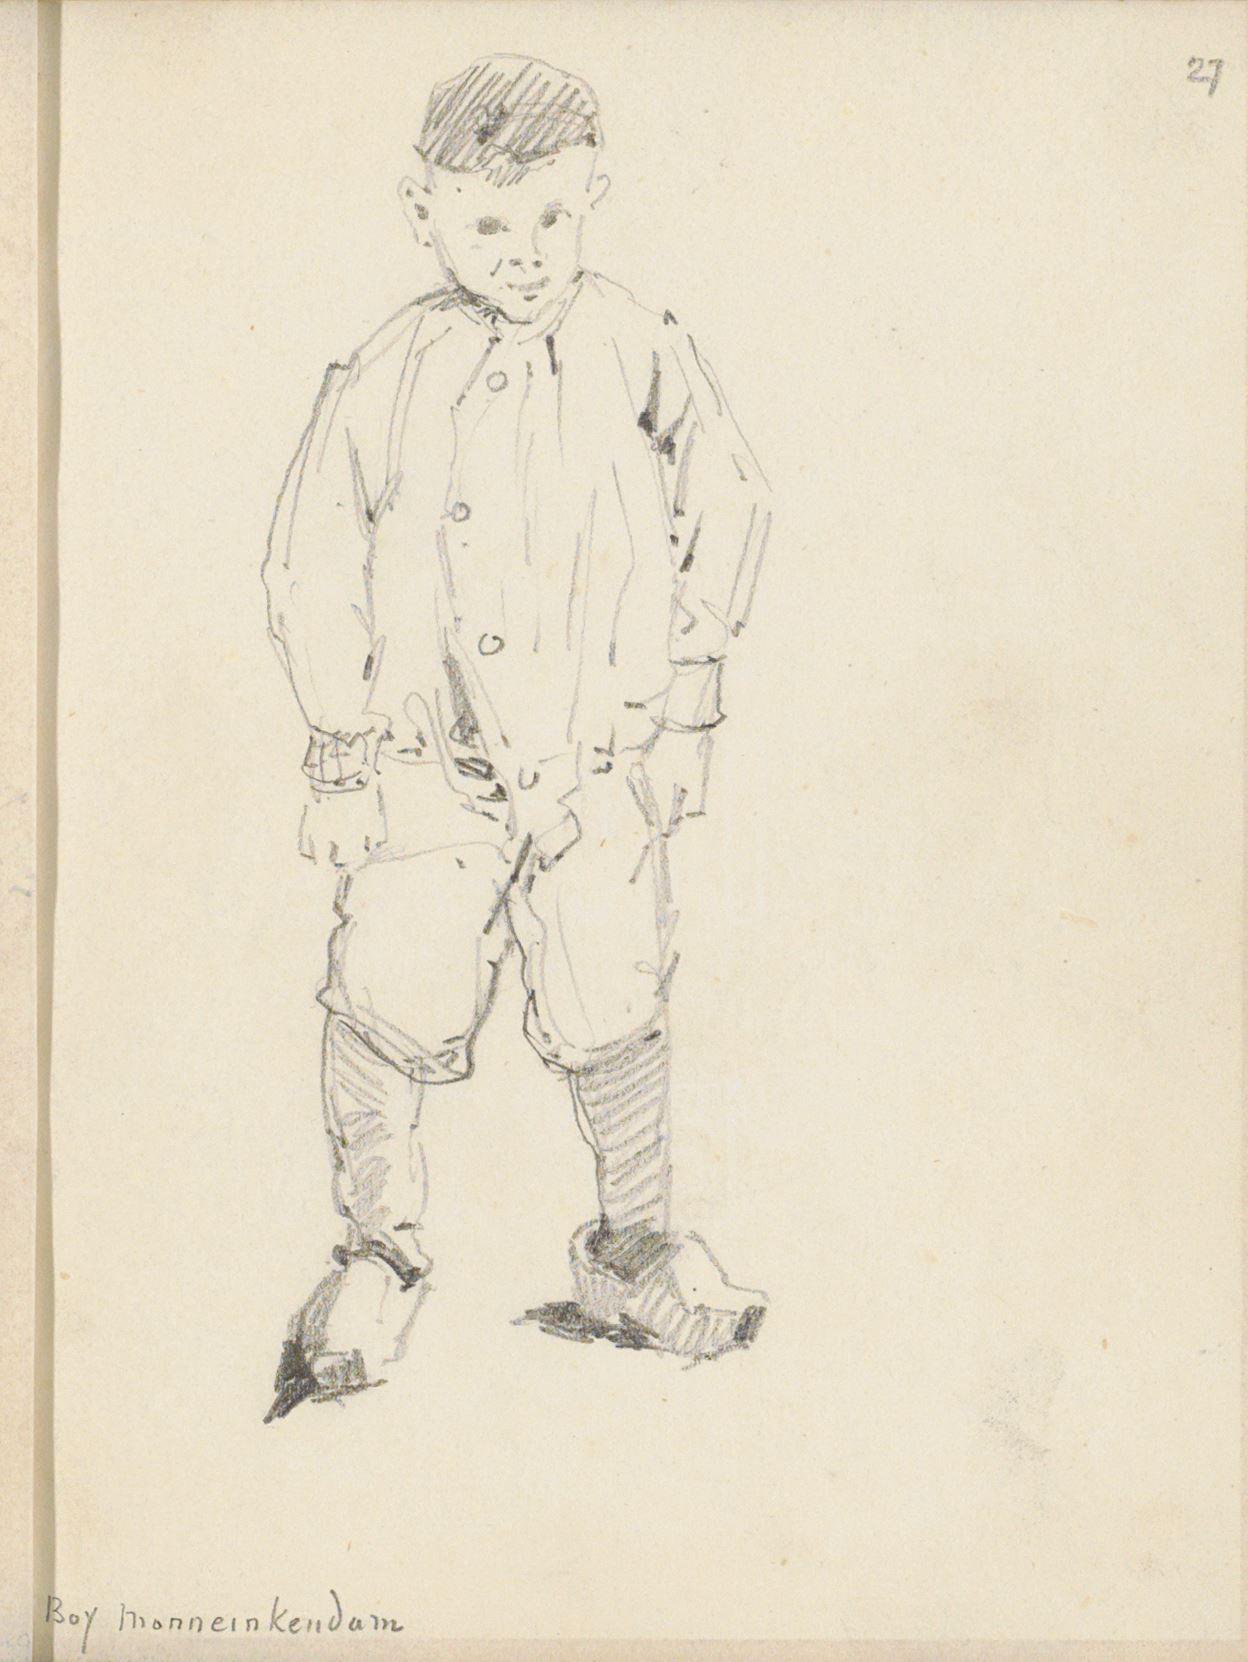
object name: sketchbook leaf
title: Jongen in Monnickendammer kostuum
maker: alfred william rich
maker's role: draughtsman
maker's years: 1856-1921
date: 1892-1893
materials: paper, pencil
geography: monnickendam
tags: folk costume, regional costume (+ men's clothes), boy (child between toddler and youth)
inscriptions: annotation: ‘Boy monneikendam’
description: Blad 27 recto uit een schetsboek met 86 bladen.